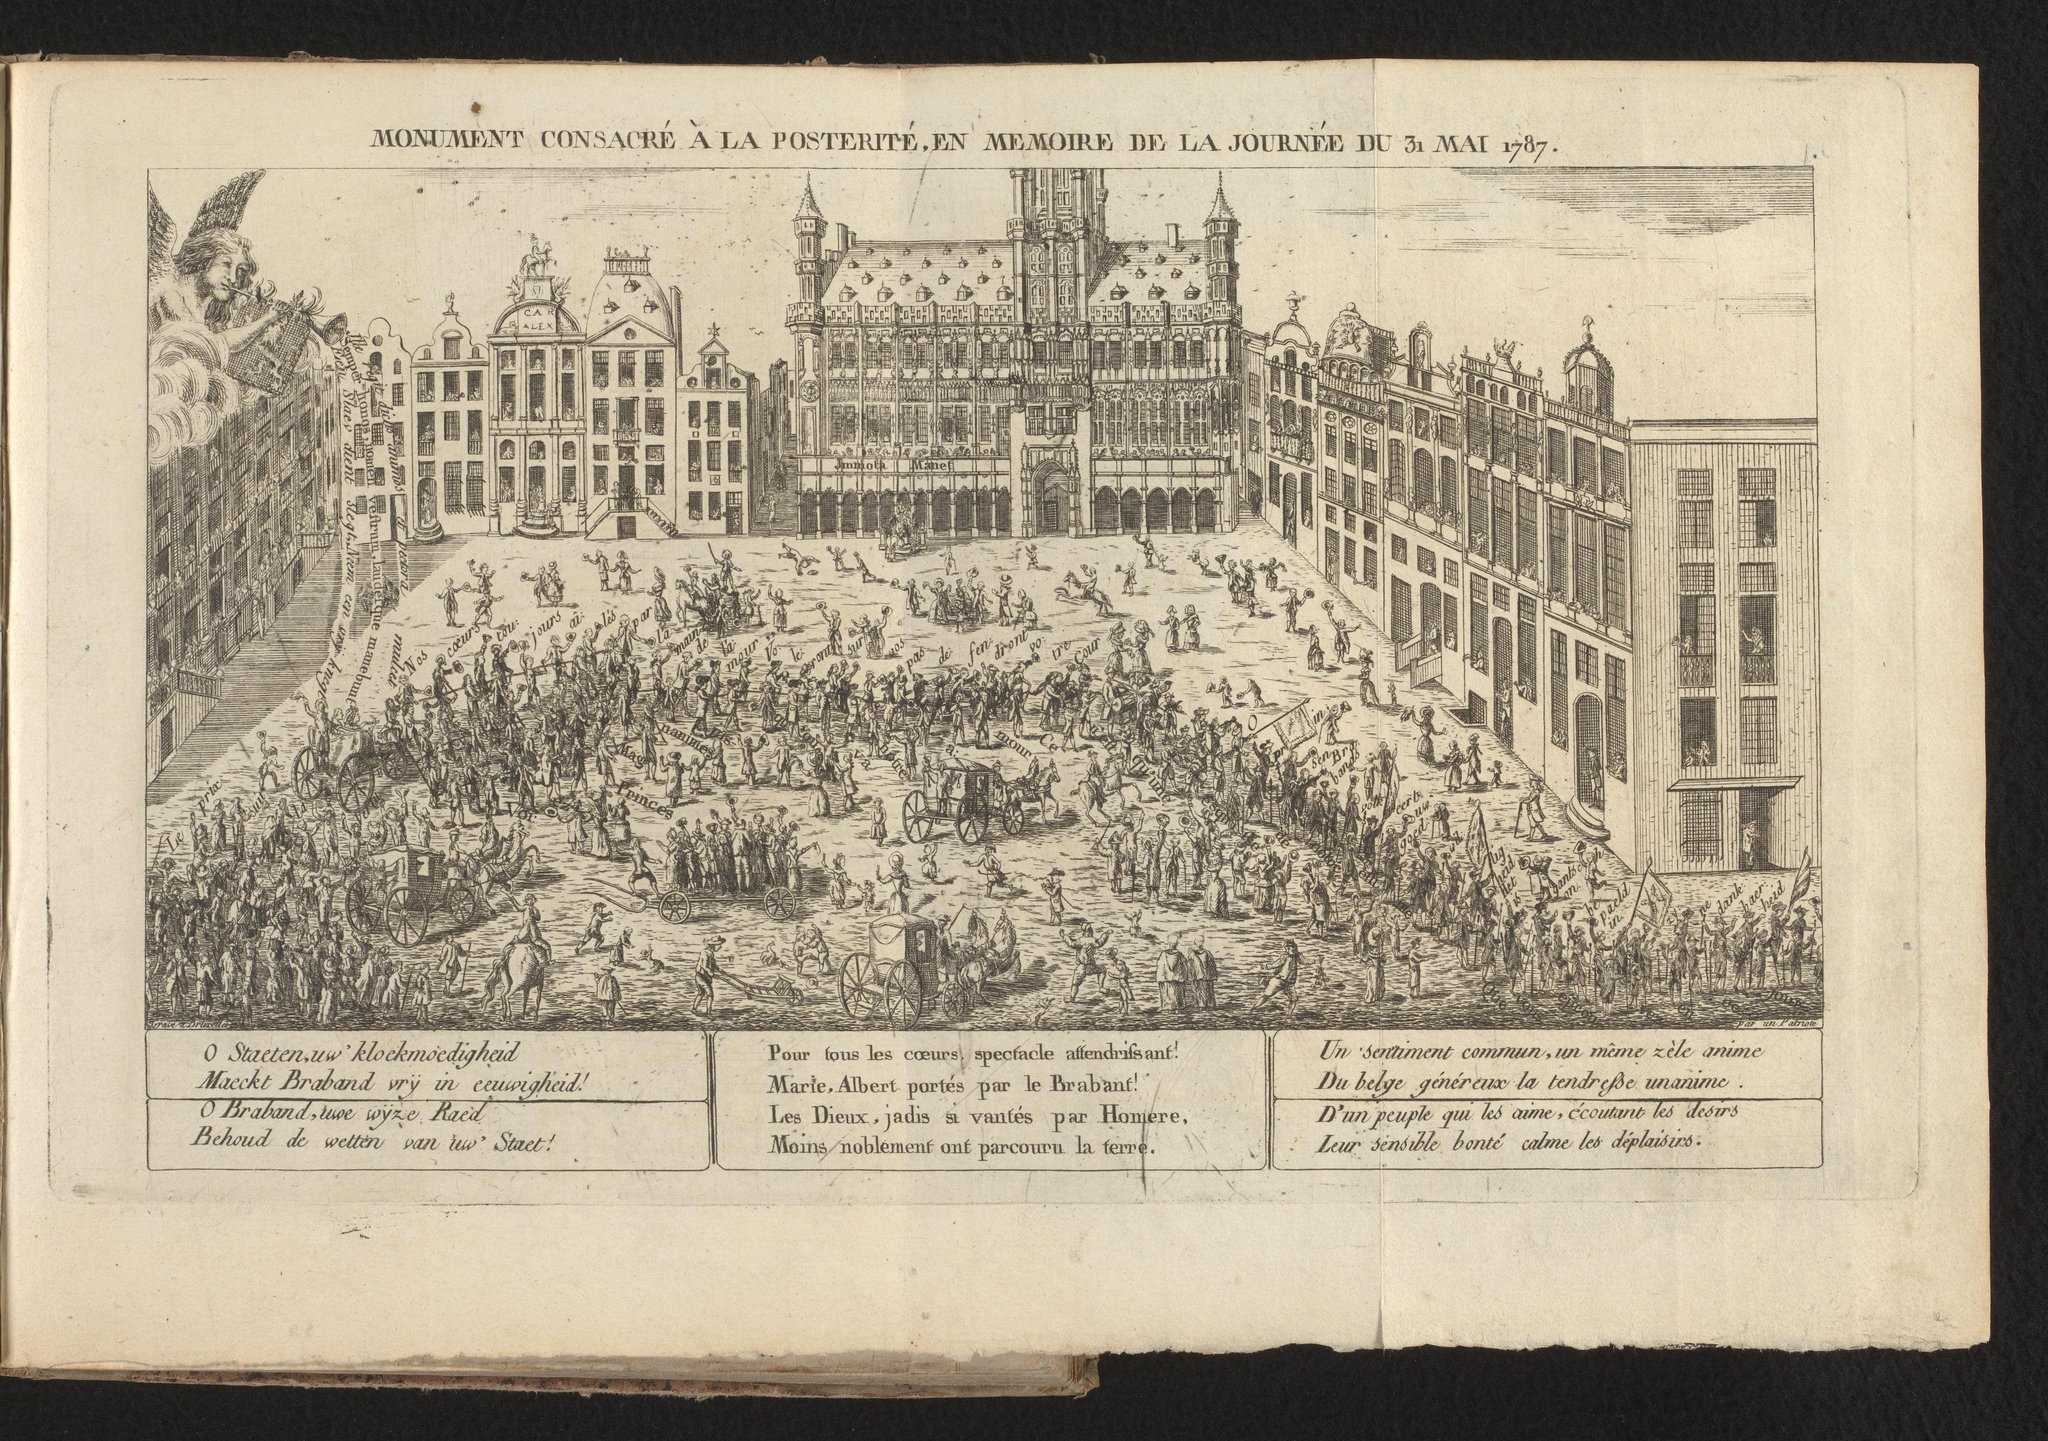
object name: print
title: Monument consacré à la posterité, en memoire de la journée du 31 mai 1787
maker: Anonymous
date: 1787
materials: paper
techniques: engraving, etching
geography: brussels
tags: revolutionary government, brabant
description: Gezicht op de Grote Markt van Brussel waar het volk bijeen is gekomen om de Staten van Brabant toe te juichen op 31 mei 1787. Met onderschriften in het Nederlands en Frans. Onderdeel van de gebundelde verzameling prenten betrekking hebbend op de gebeurtenissen van de Brabantse Omwenteling en de periode 1787-1790.